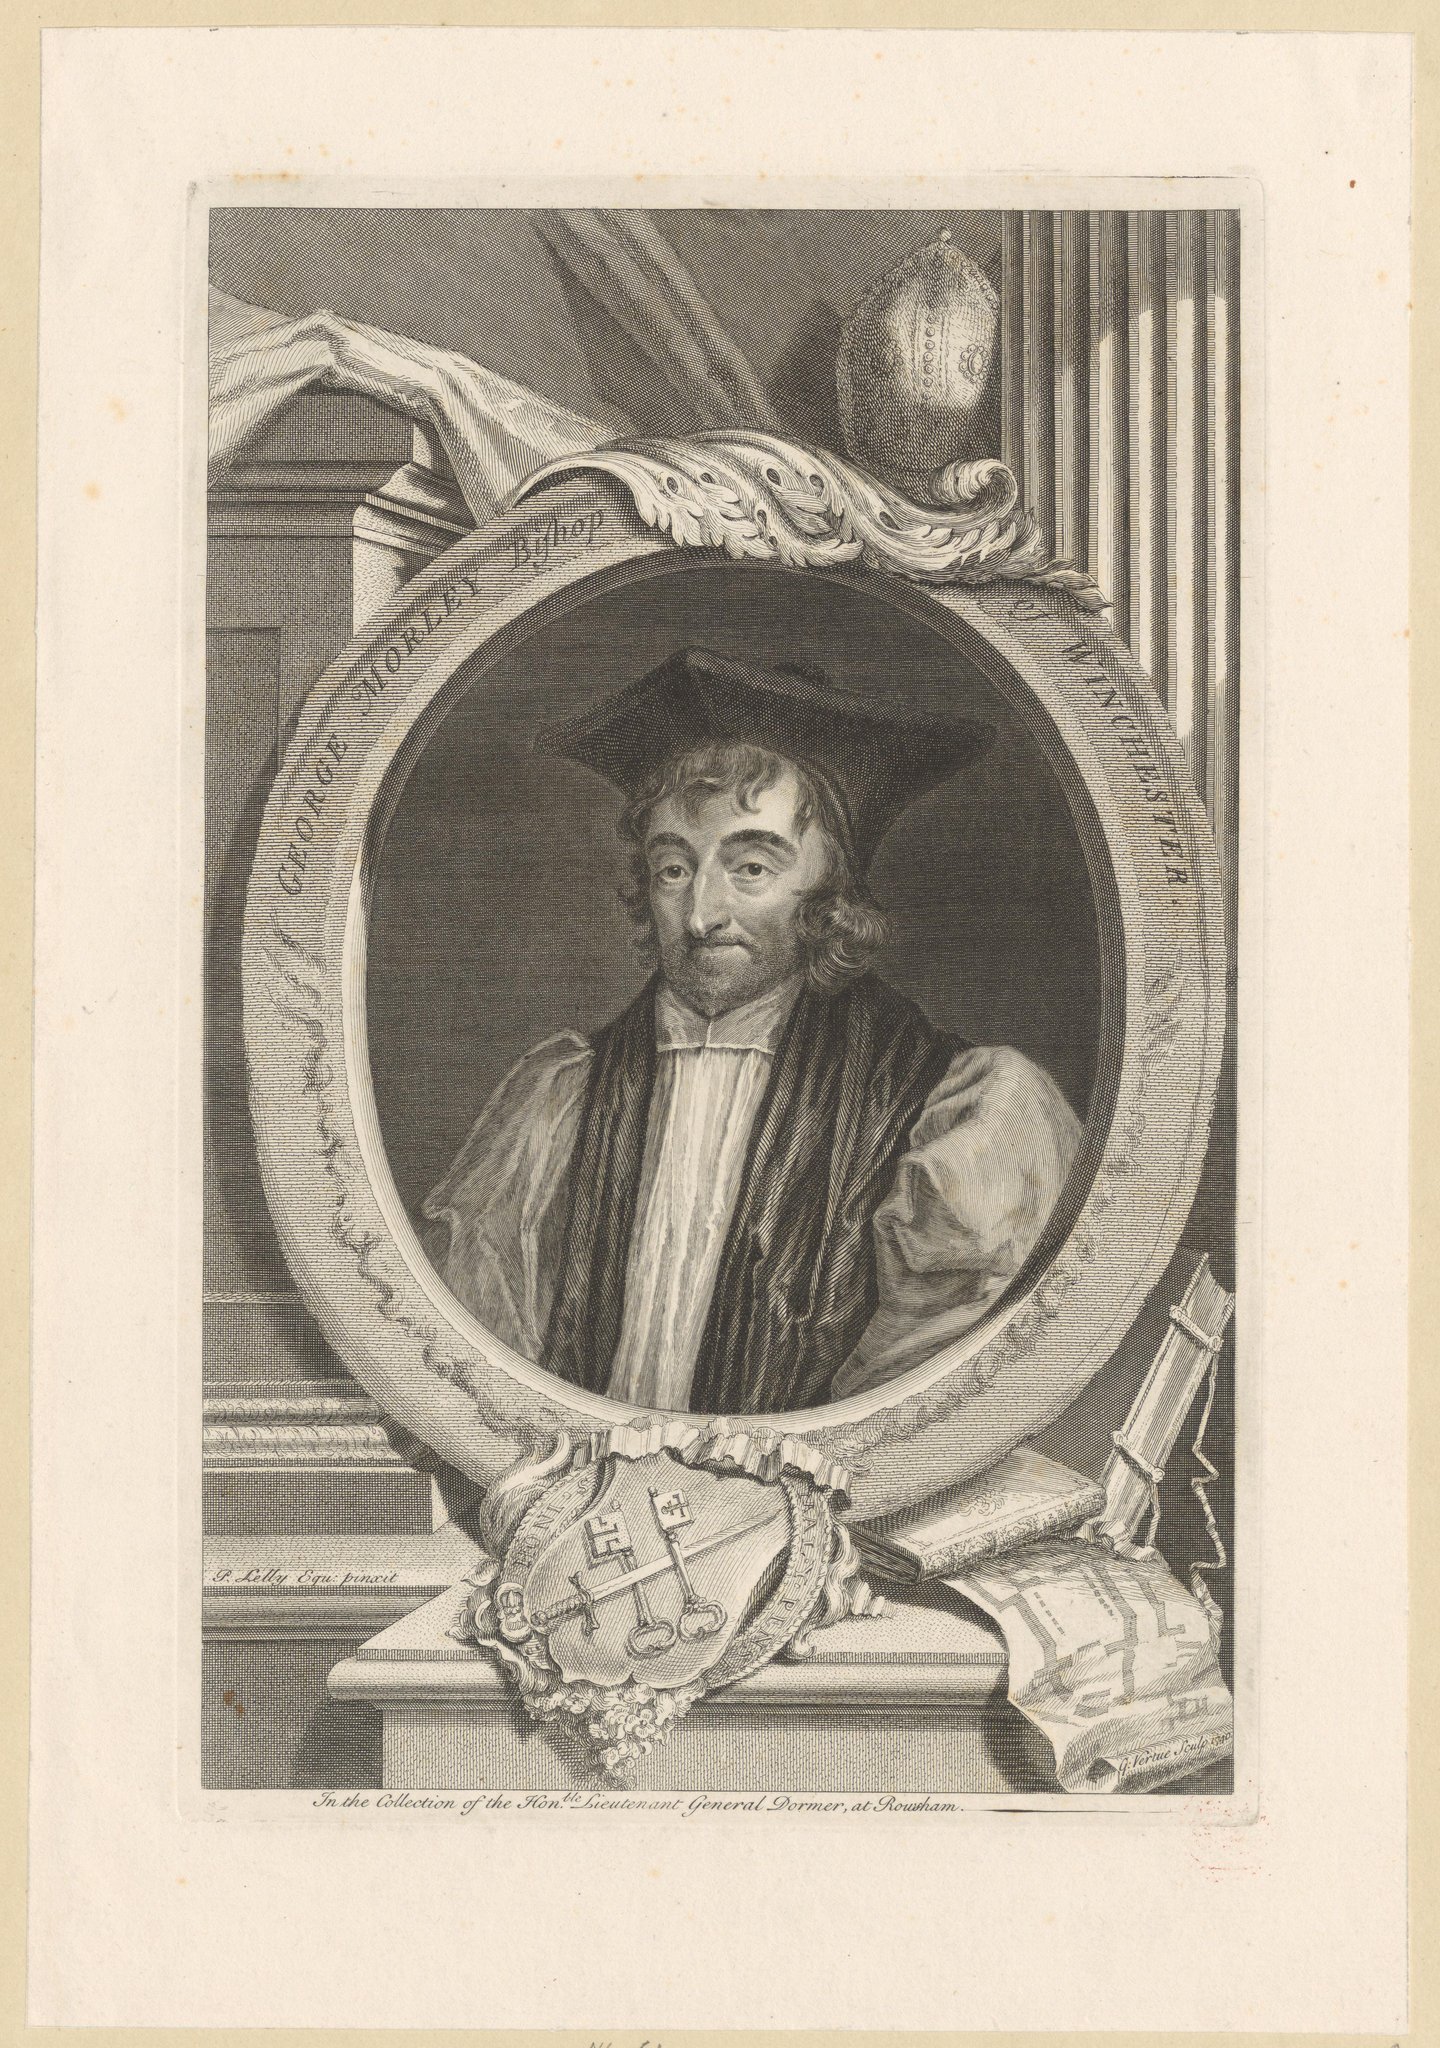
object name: print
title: Portret van George Morley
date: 1740-1747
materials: paper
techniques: engraving, etching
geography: london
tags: archbishop, bishop, etc. (roman catholic), historical persons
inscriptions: collector's mark: Lugt 240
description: Prent gebruikt in: Birch, Thomas. The heads of illustrious persons of Great Britain (...). Londen: John & Paul Knapton, 1747, p. 120.